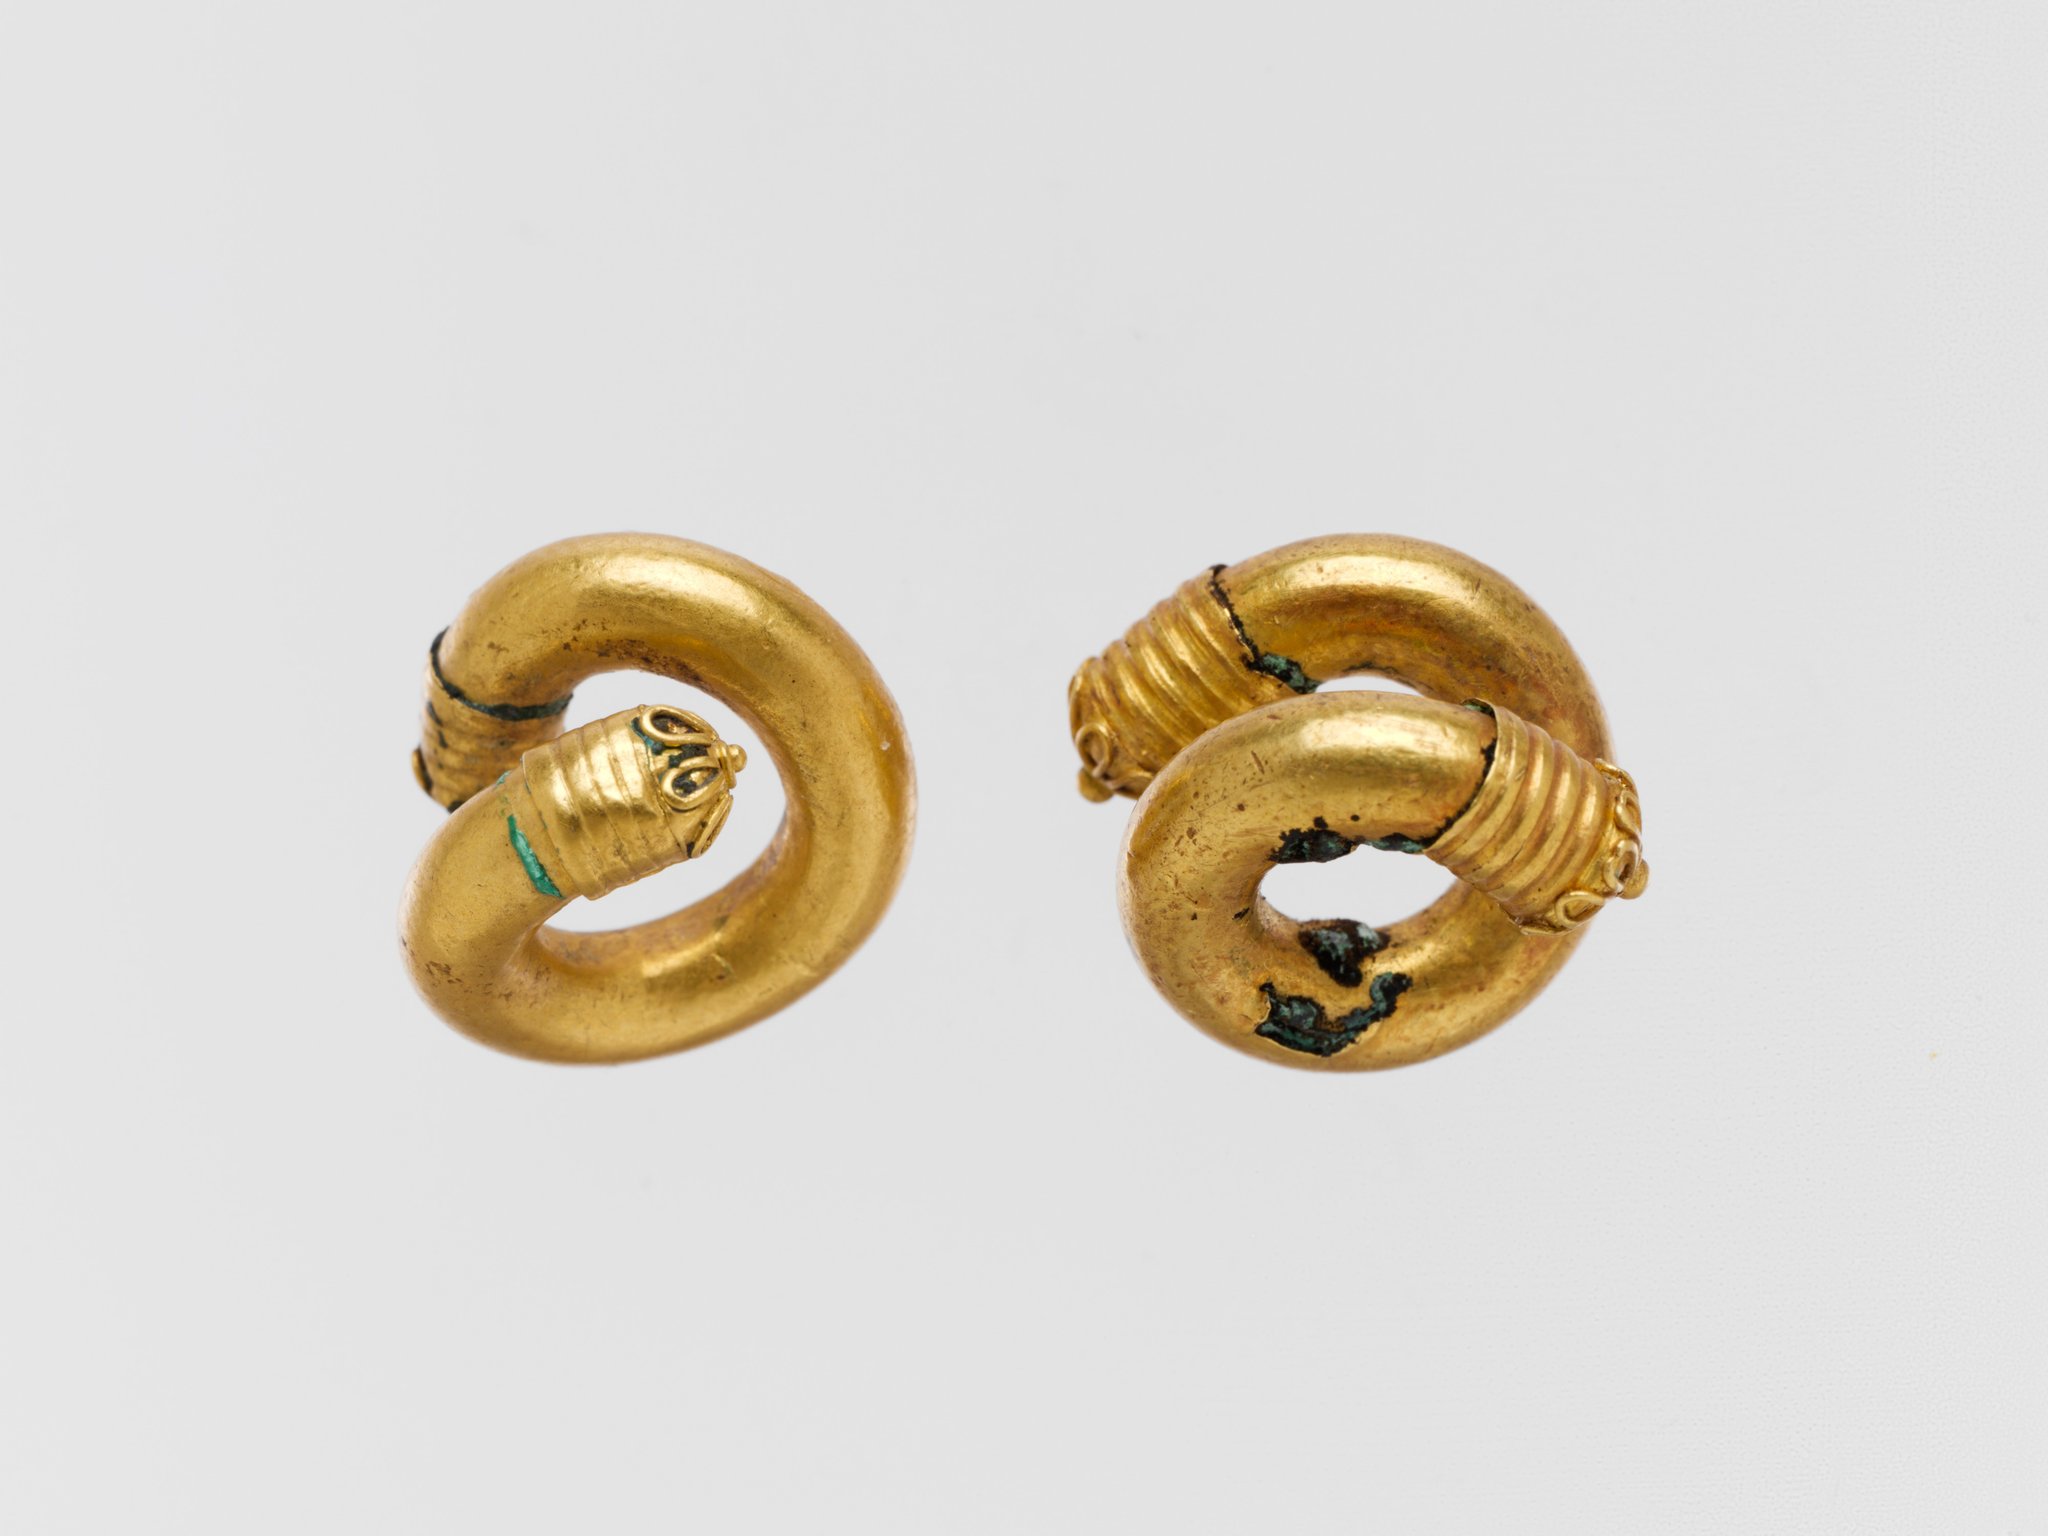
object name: earring or spiral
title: Gold and copper alloy spiral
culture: cypriot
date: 500-401 BCE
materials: bronze, gold